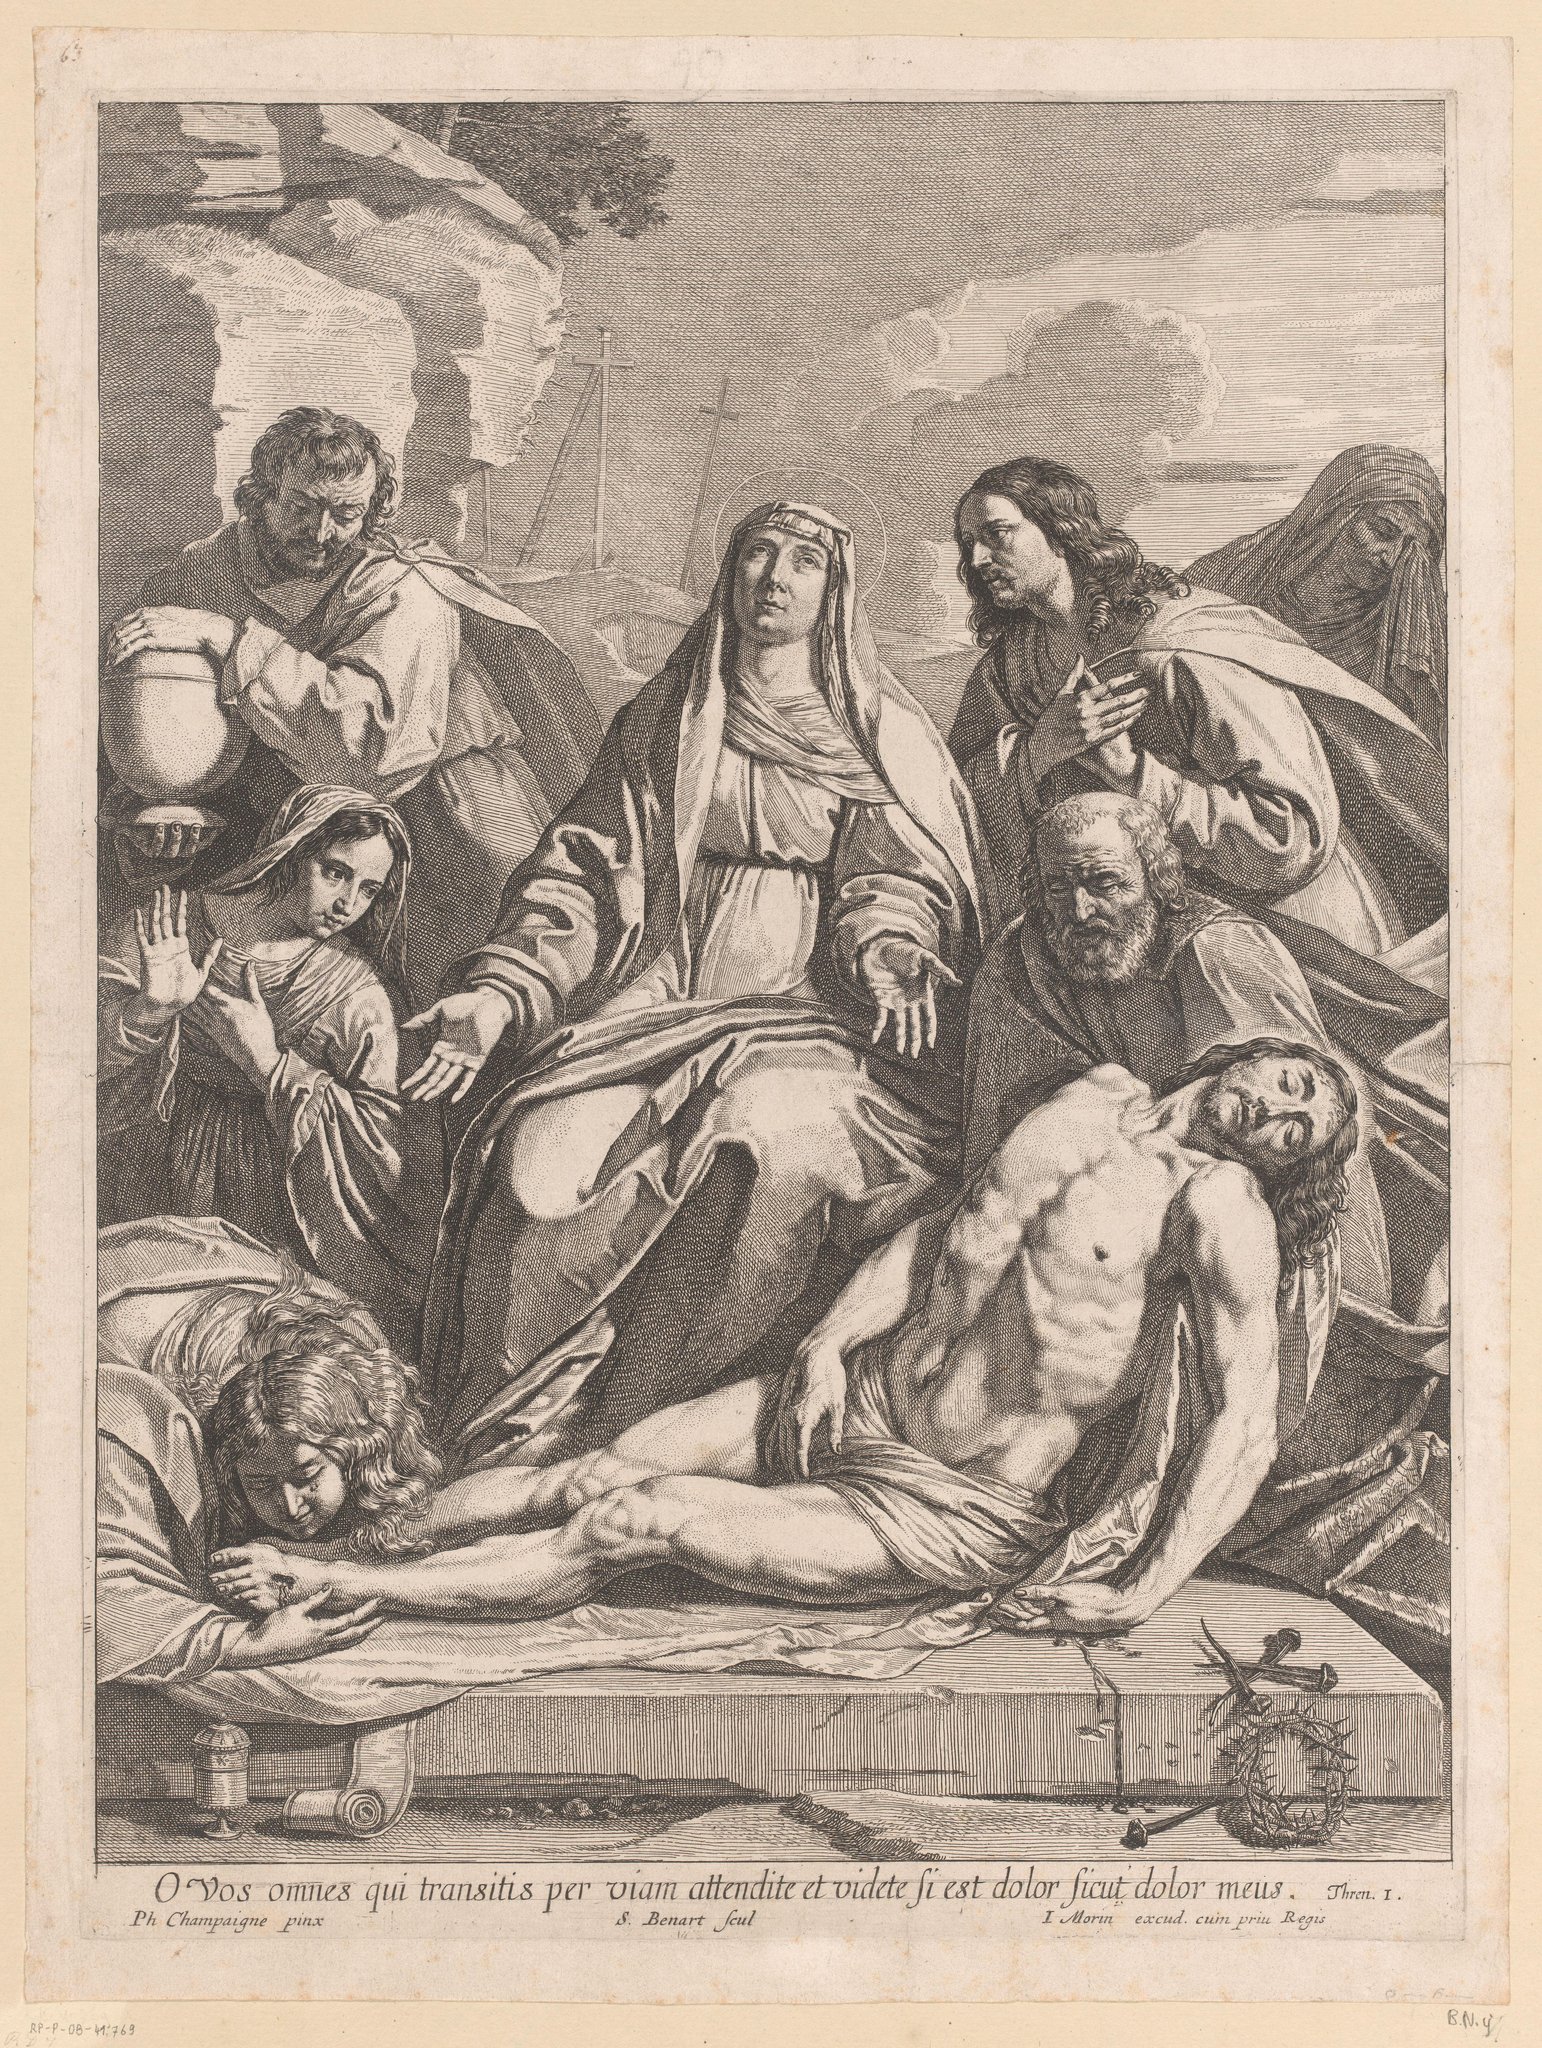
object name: print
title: Bewening van Christus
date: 1625-1656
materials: paper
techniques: engraving, etching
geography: france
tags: the cross(es) in the background, single instruments of the passion, lamentation over the dead christ by his relatives and friends (christ usually without crown of thorns)